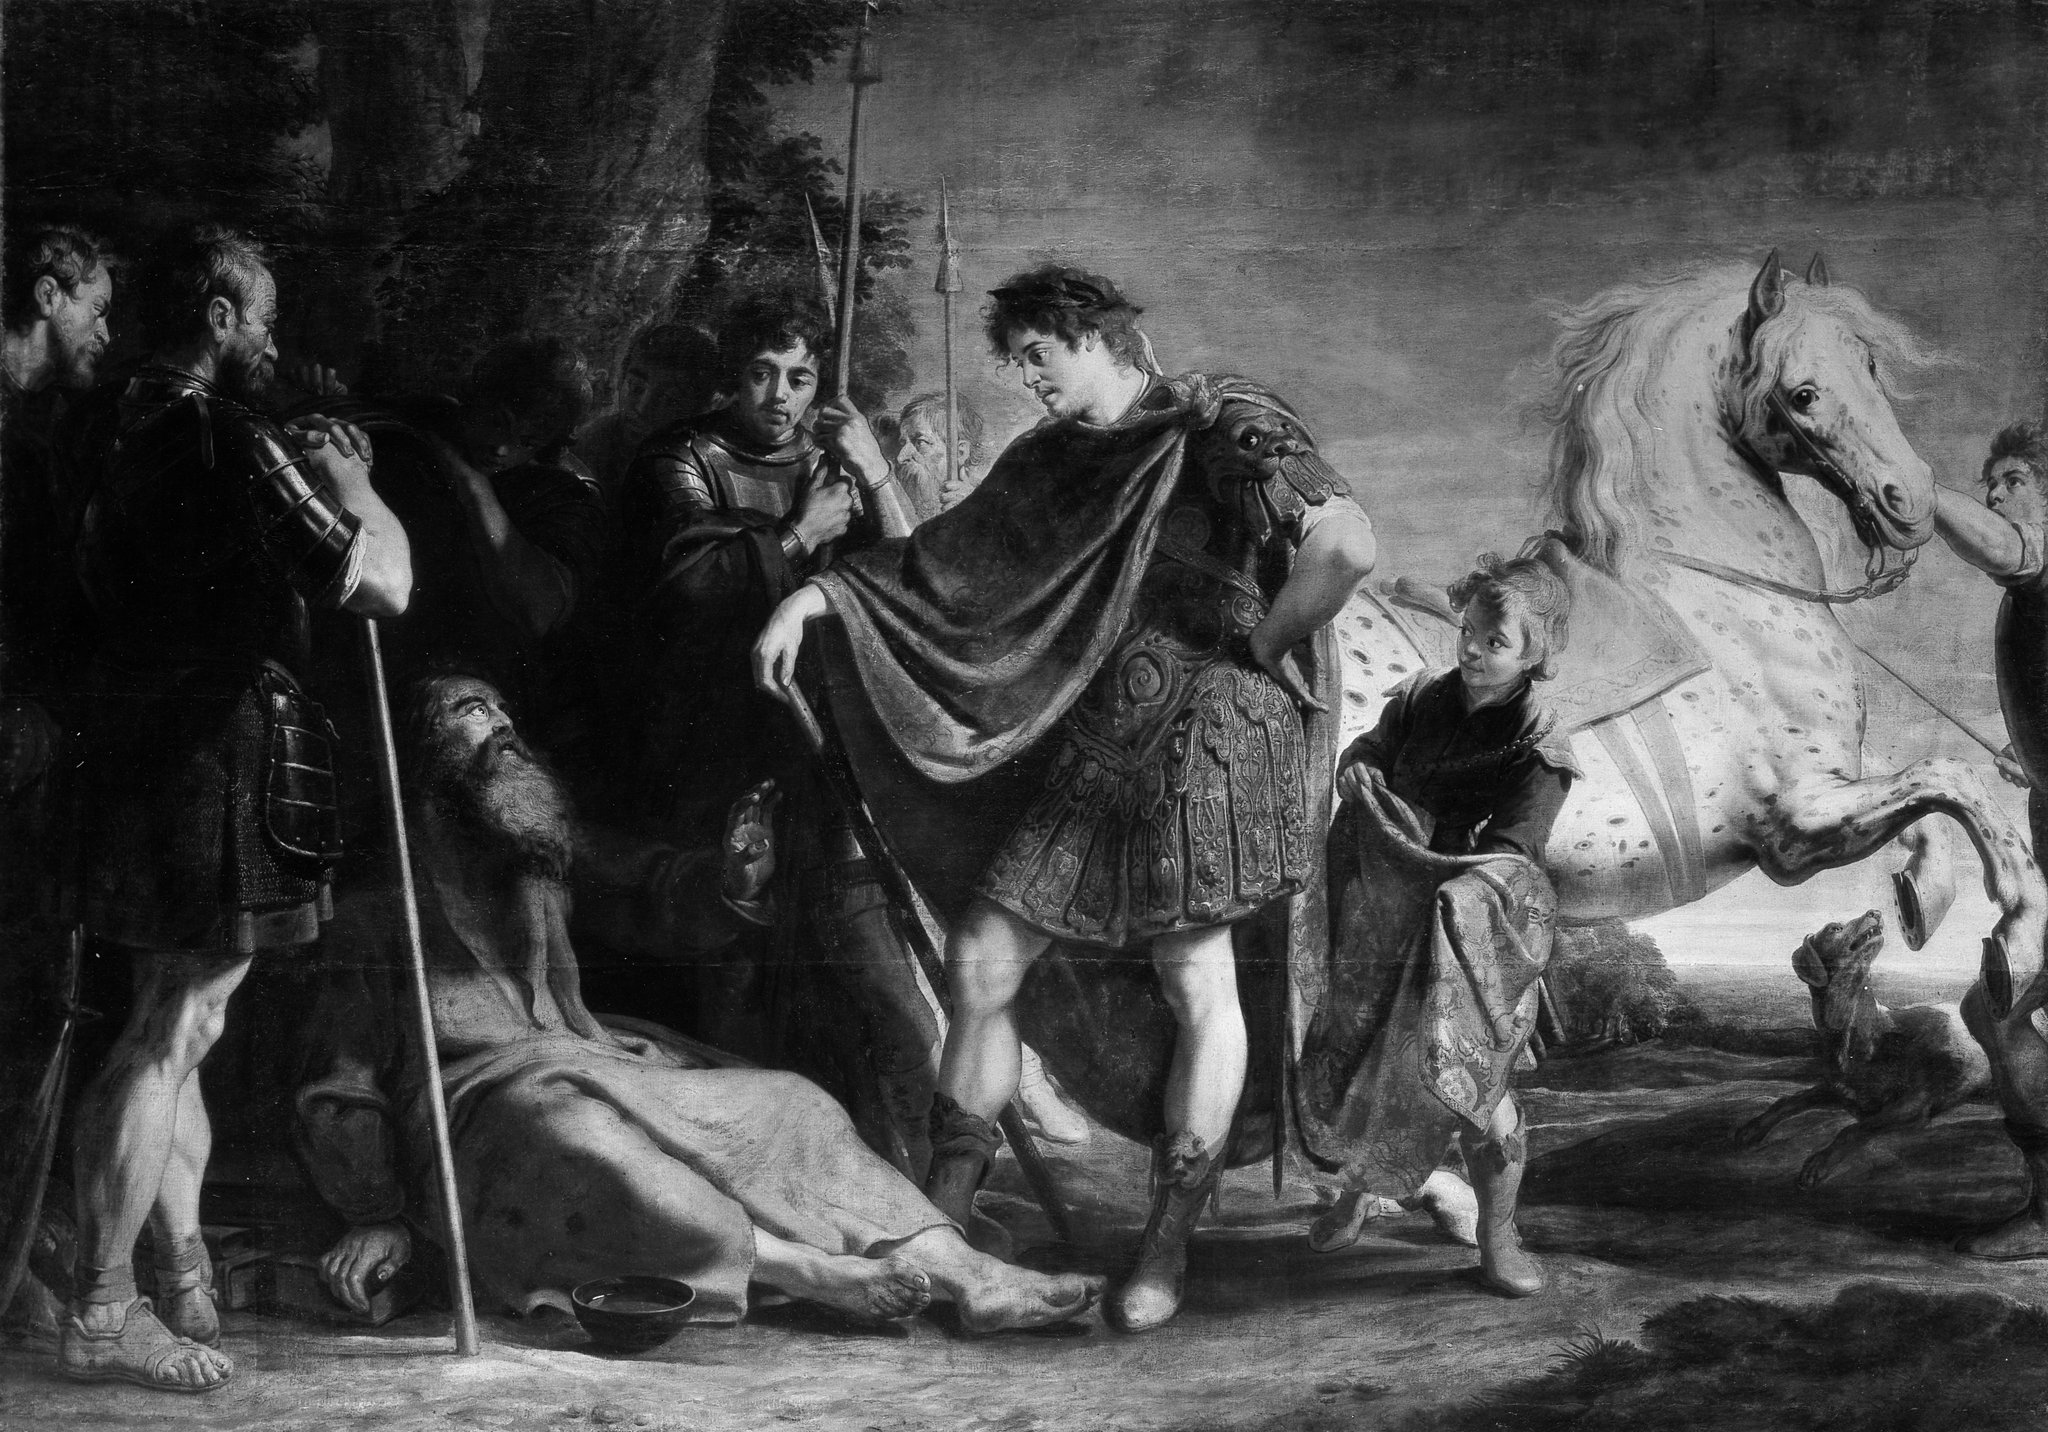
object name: painting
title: The Meeting of Alexander the Great and Diogenes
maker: gaspar de crayer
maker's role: artist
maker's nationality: flemish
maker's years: 1584-1669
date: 1605-1669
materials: canvas, oil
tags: alexander the great,diogenes,boys,horses